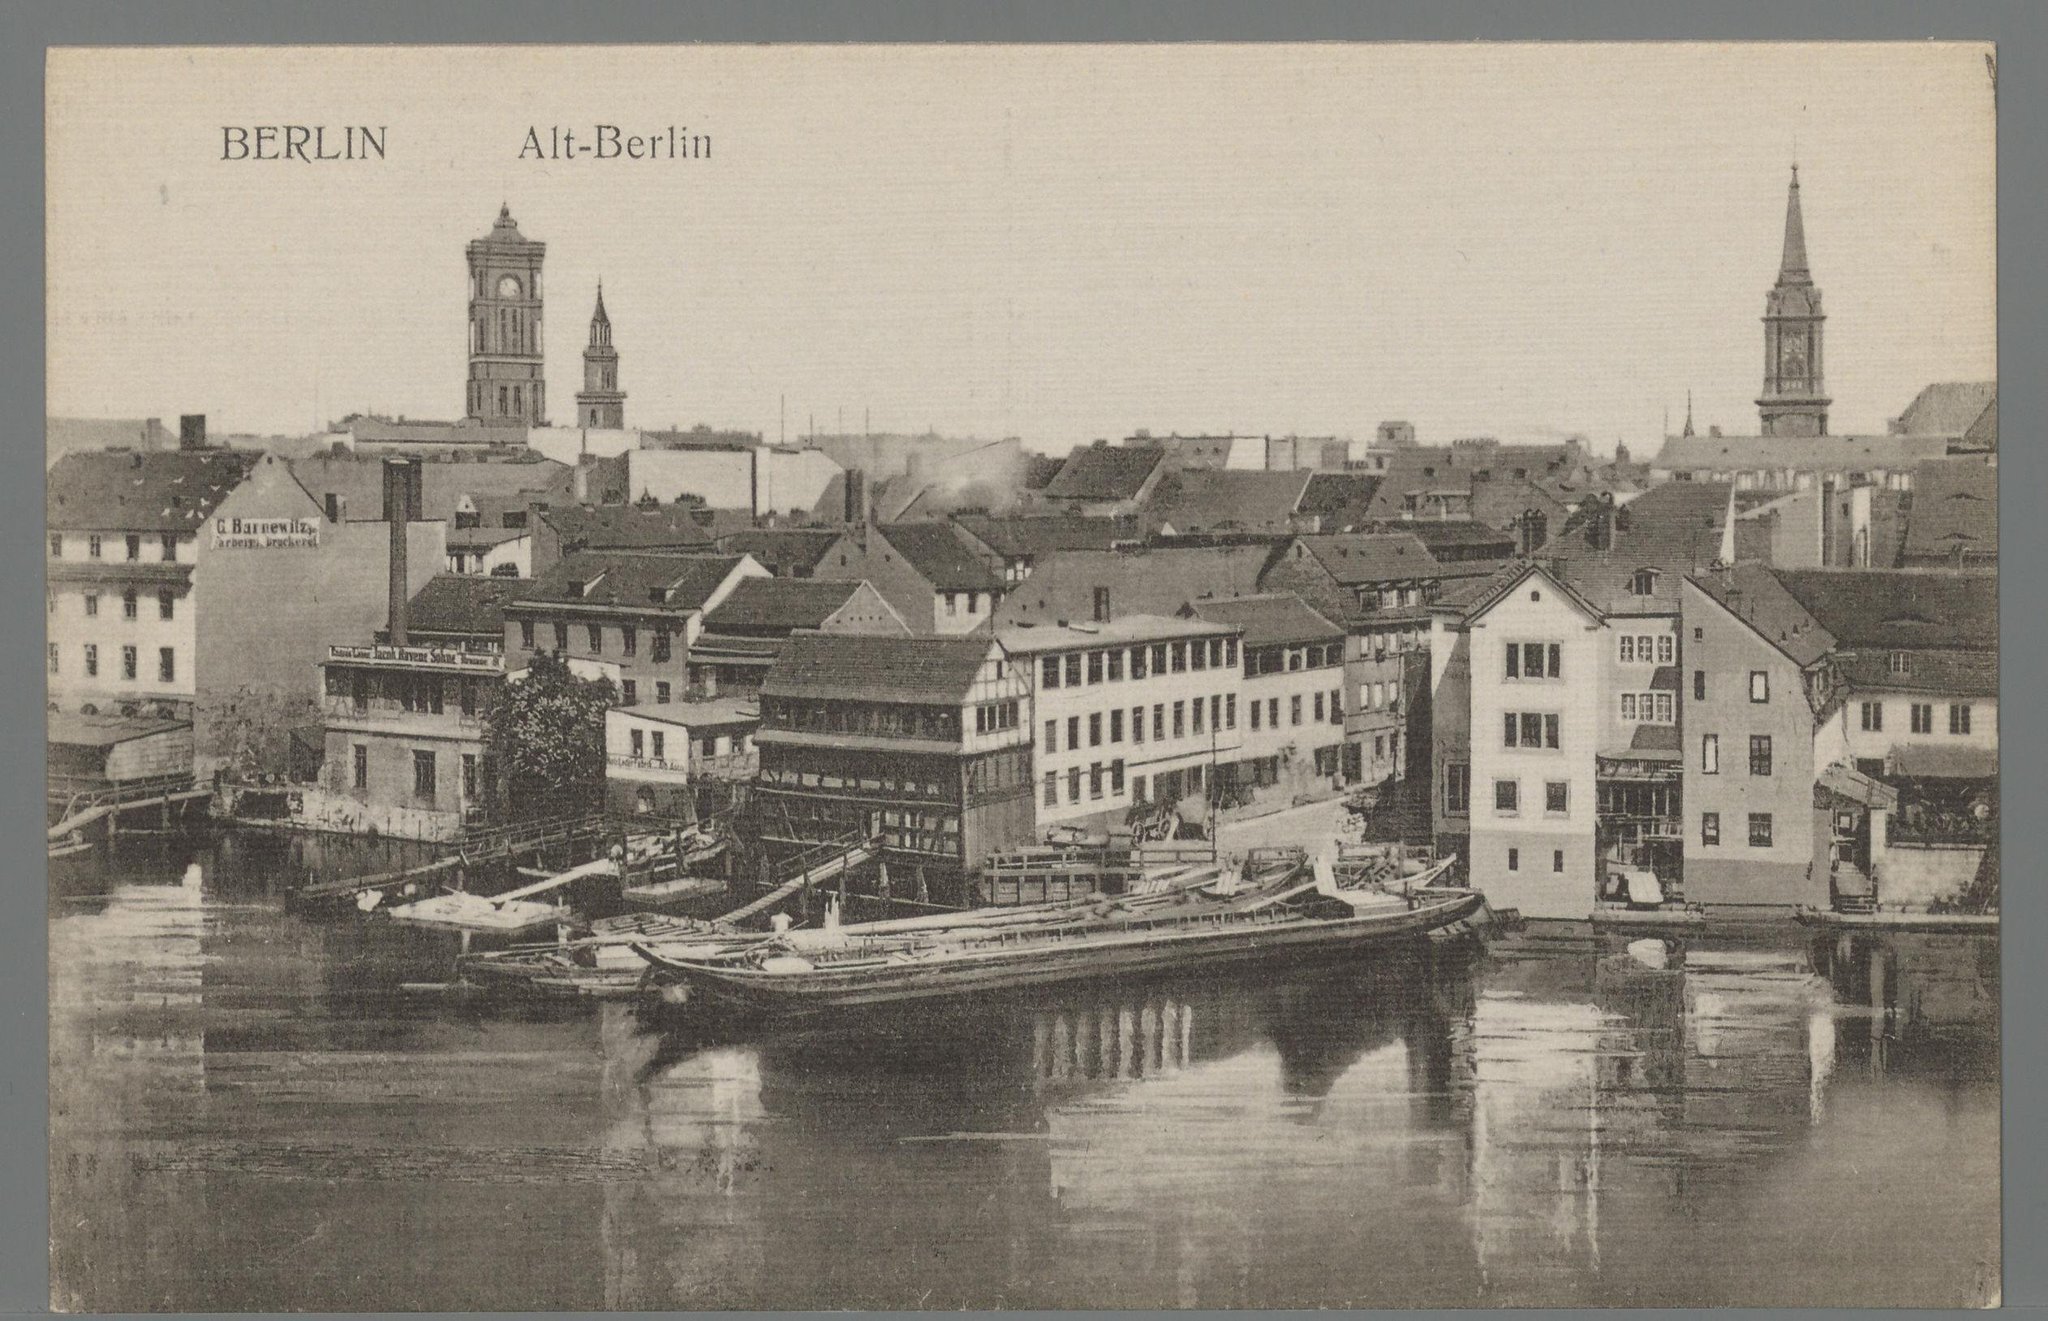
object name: ansichtkaart, prentbriefkaart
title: Berlin. Alt-Berlin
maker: Anonymous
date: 1905-1930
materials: cardboard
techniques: photograph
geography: berlin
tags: city-view, and landscape with man-made constructions, canals, waters (in city), berlin